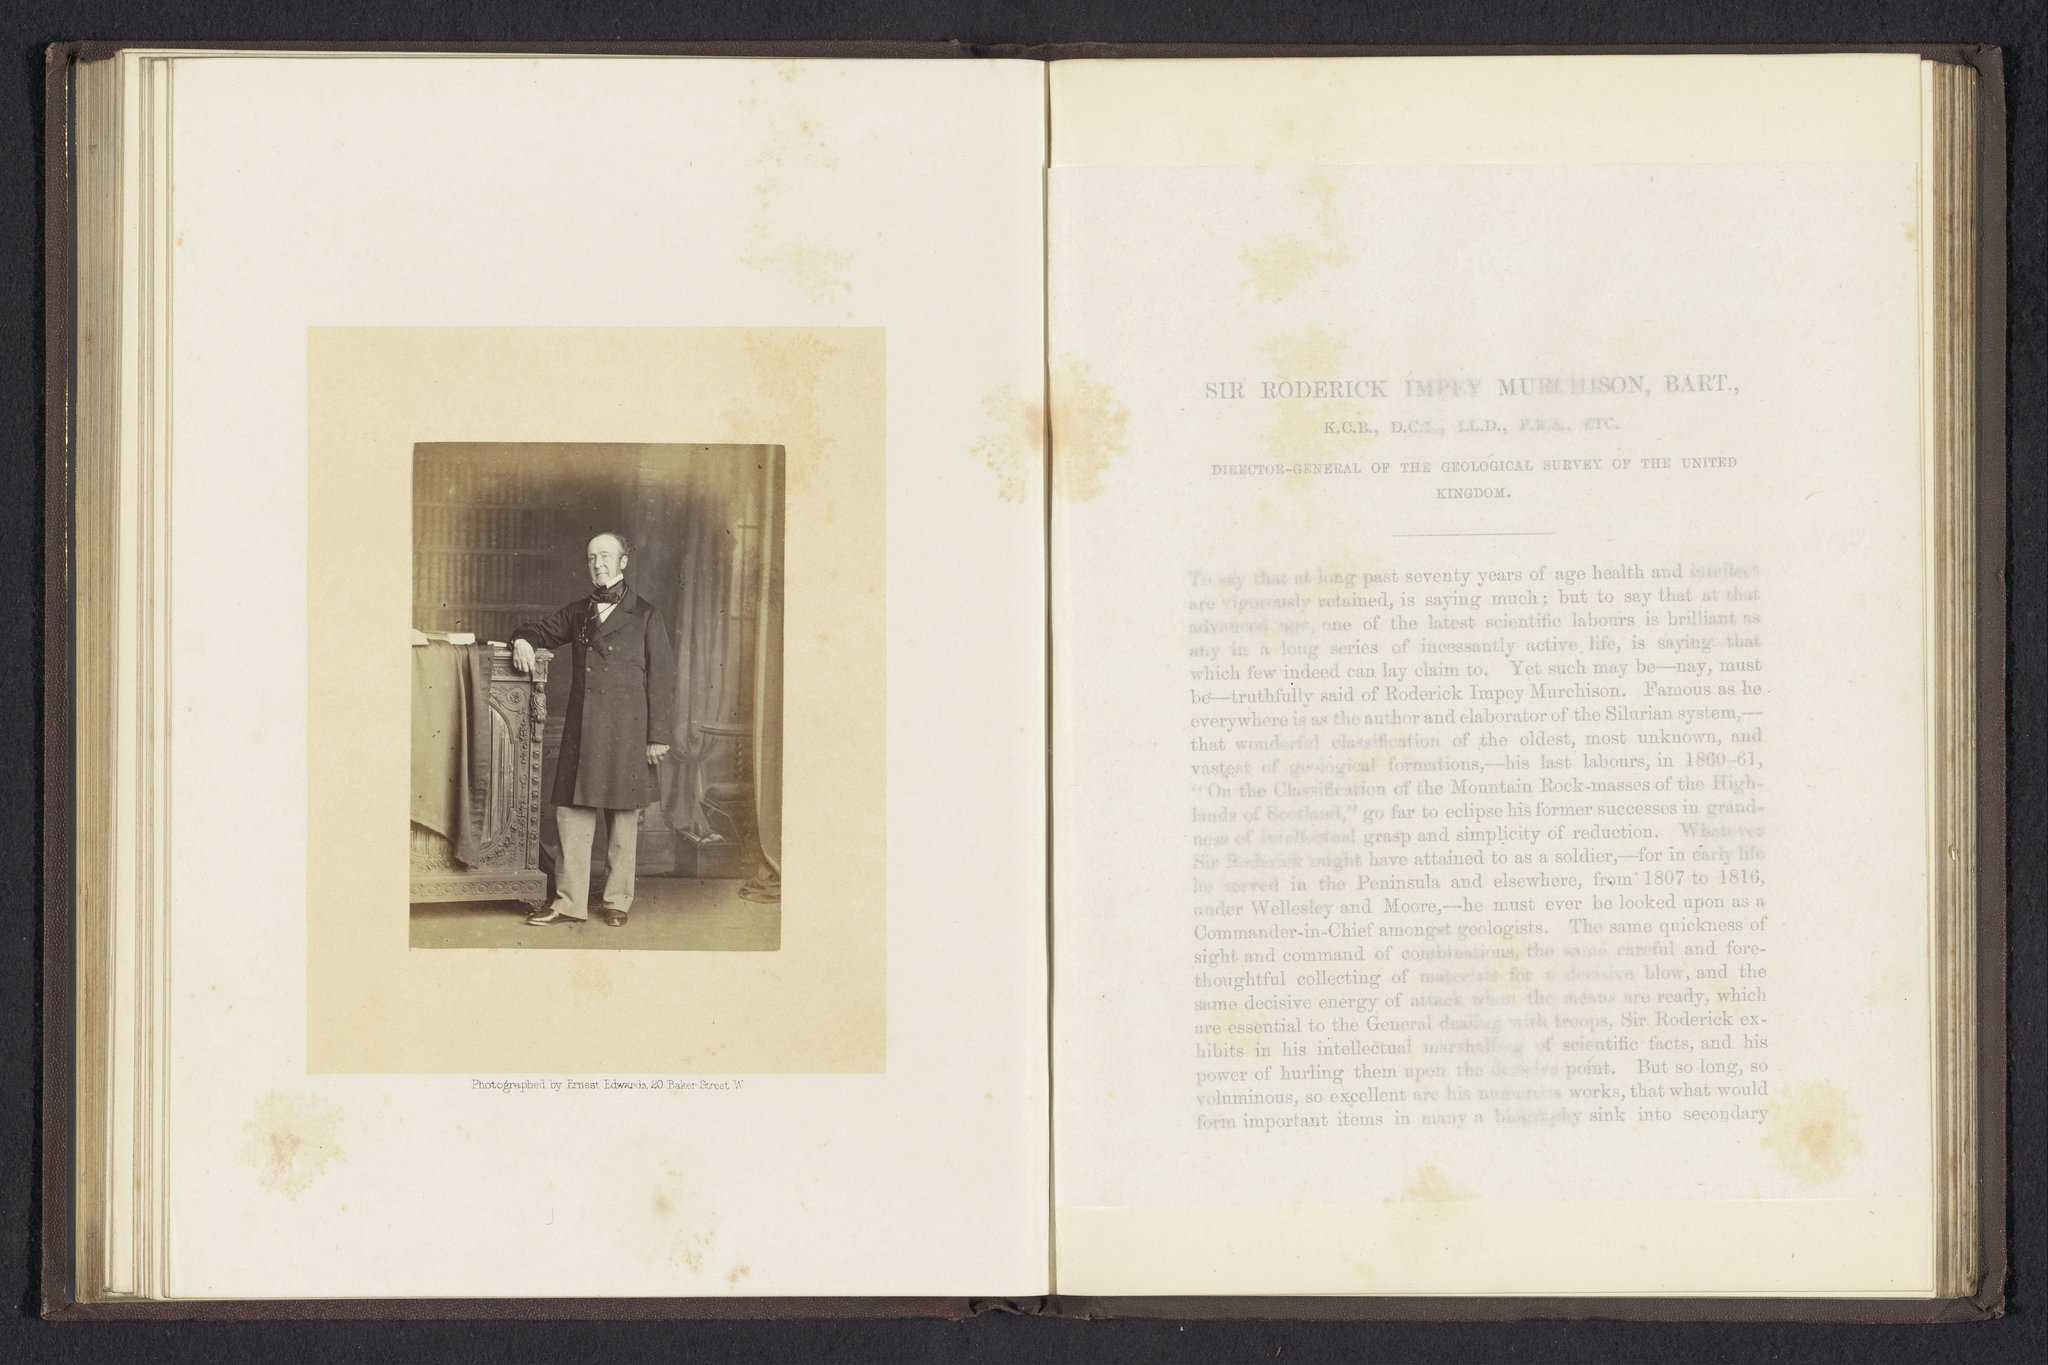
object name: page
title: Portret van Roderick Murchison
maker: ernest edwards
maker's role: fotograaf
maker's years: 1837-1903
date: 1858-1868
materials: paper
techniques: albumen print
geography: london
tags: geology, historical persons